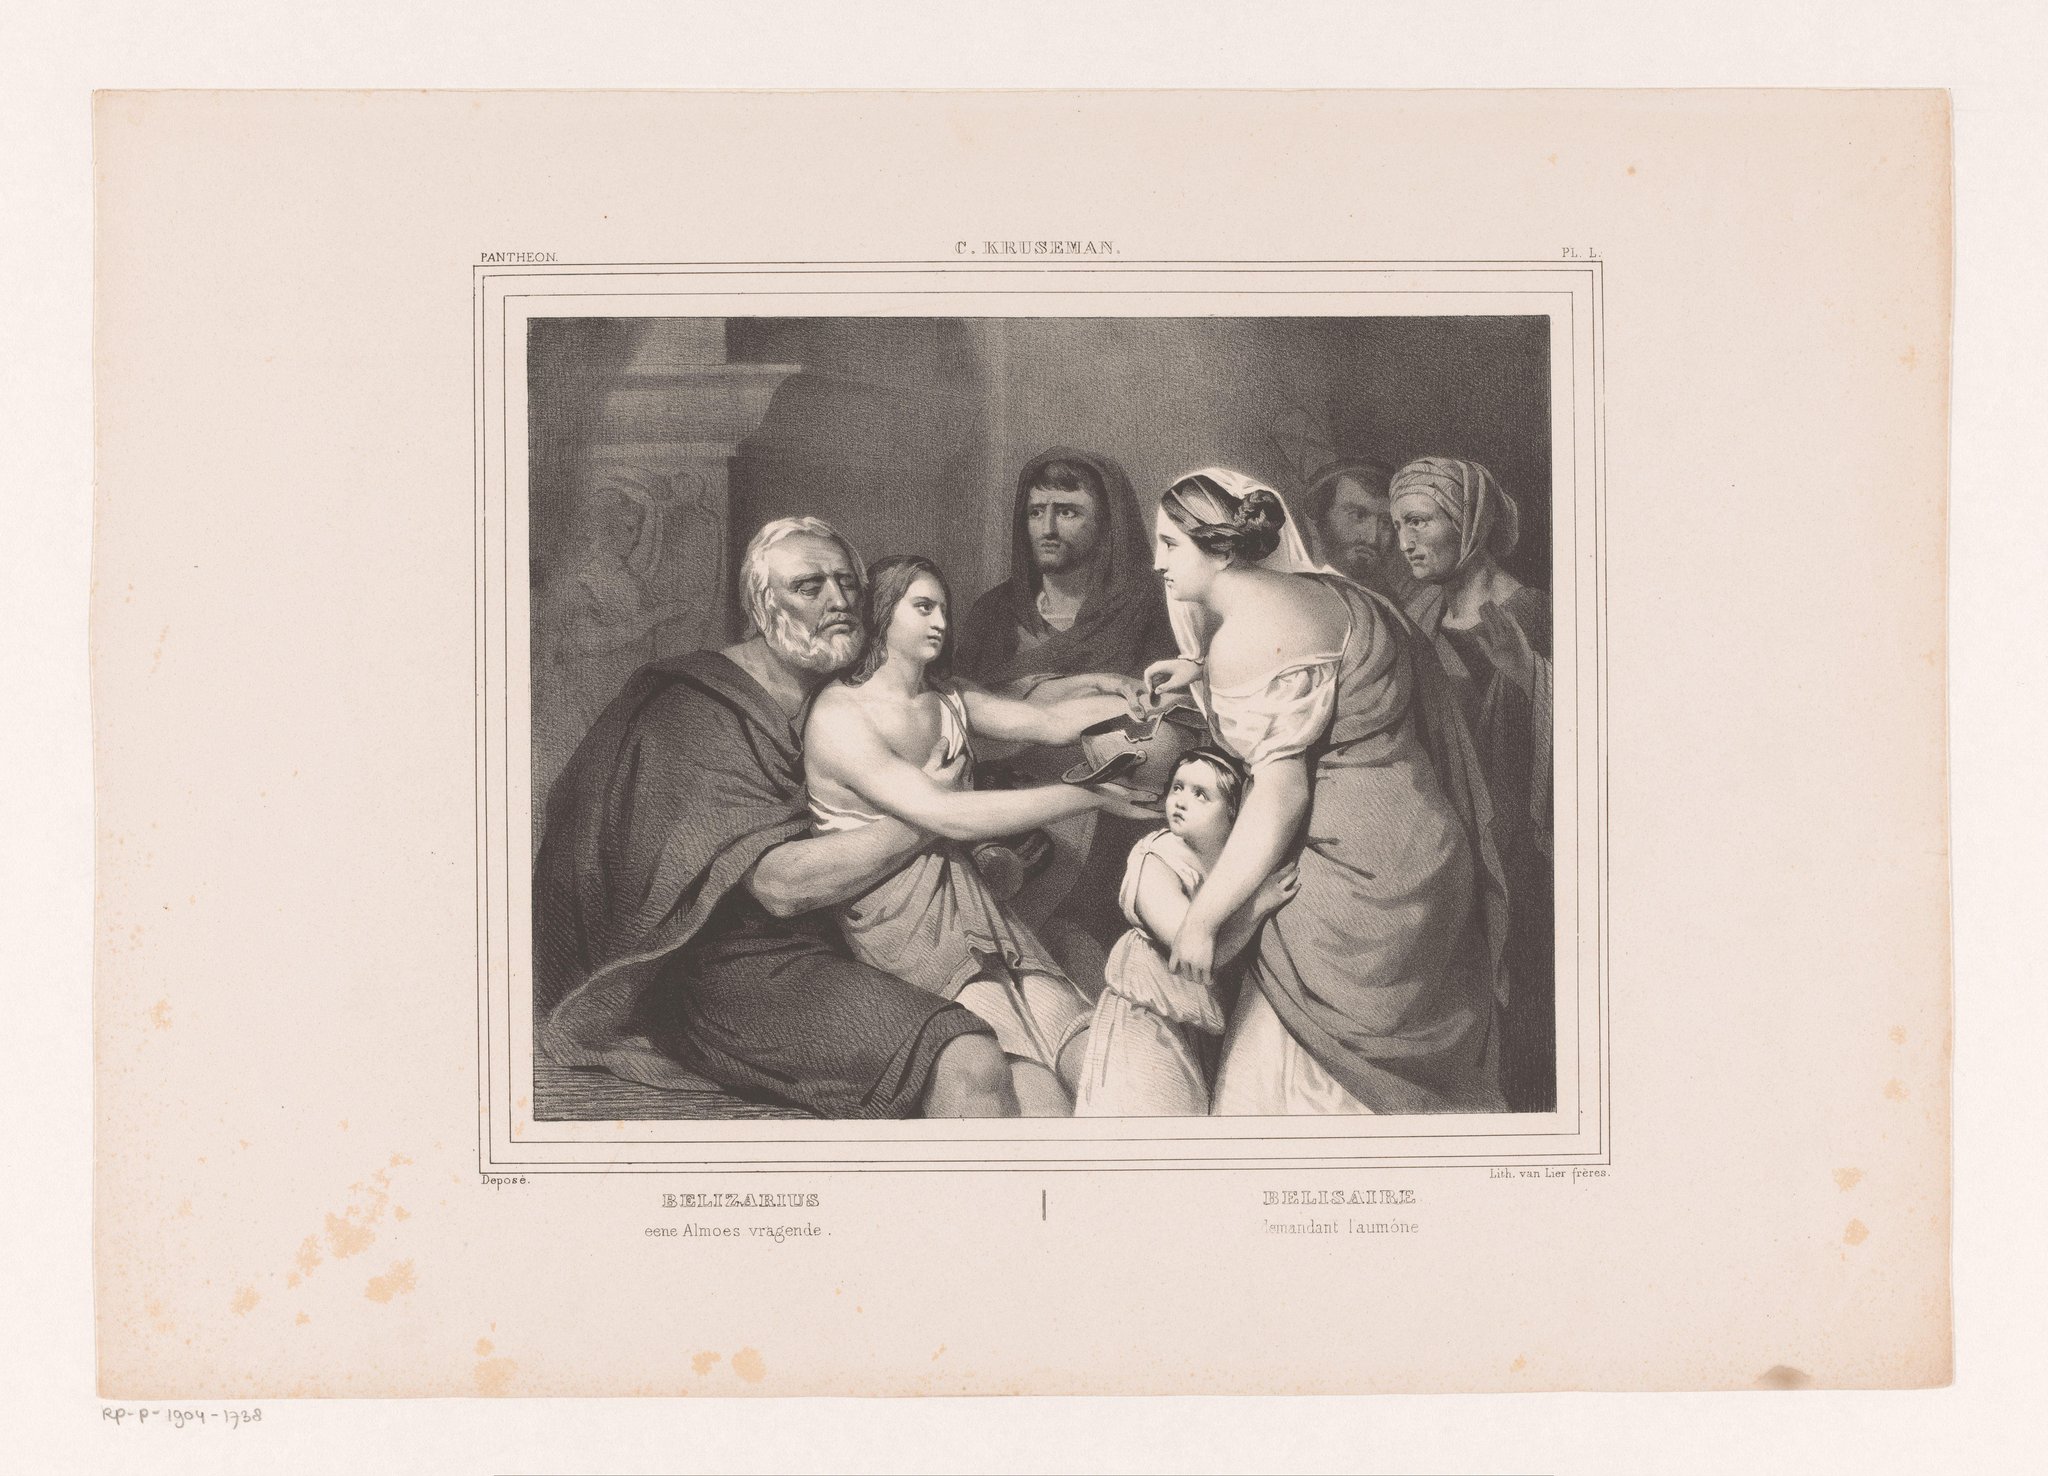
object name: print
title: Belizarius, eene aalmoes vragende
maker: cornelis kruseman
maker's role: draughtsman, painter, print maker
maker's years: 1797-1857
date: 1837-1843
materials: paper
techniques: lithograph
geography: the hague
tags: giving alms or other charity, e.g.: handing out food, blind, blindness, beggar, belisarius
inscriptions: collector's mark: Lugt 2228, : ‘Deposé’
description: De blinde generaal Belisarius zit met zijn gids op schoot. Een vrouw doet een muntstuk in de helm die hij vragend uitsteekt. In de achtergrond, met hoofddoek, waarschijnlijk de toekomstige keizer Tiberus. Genummerd rechtsboven: Pl. L.